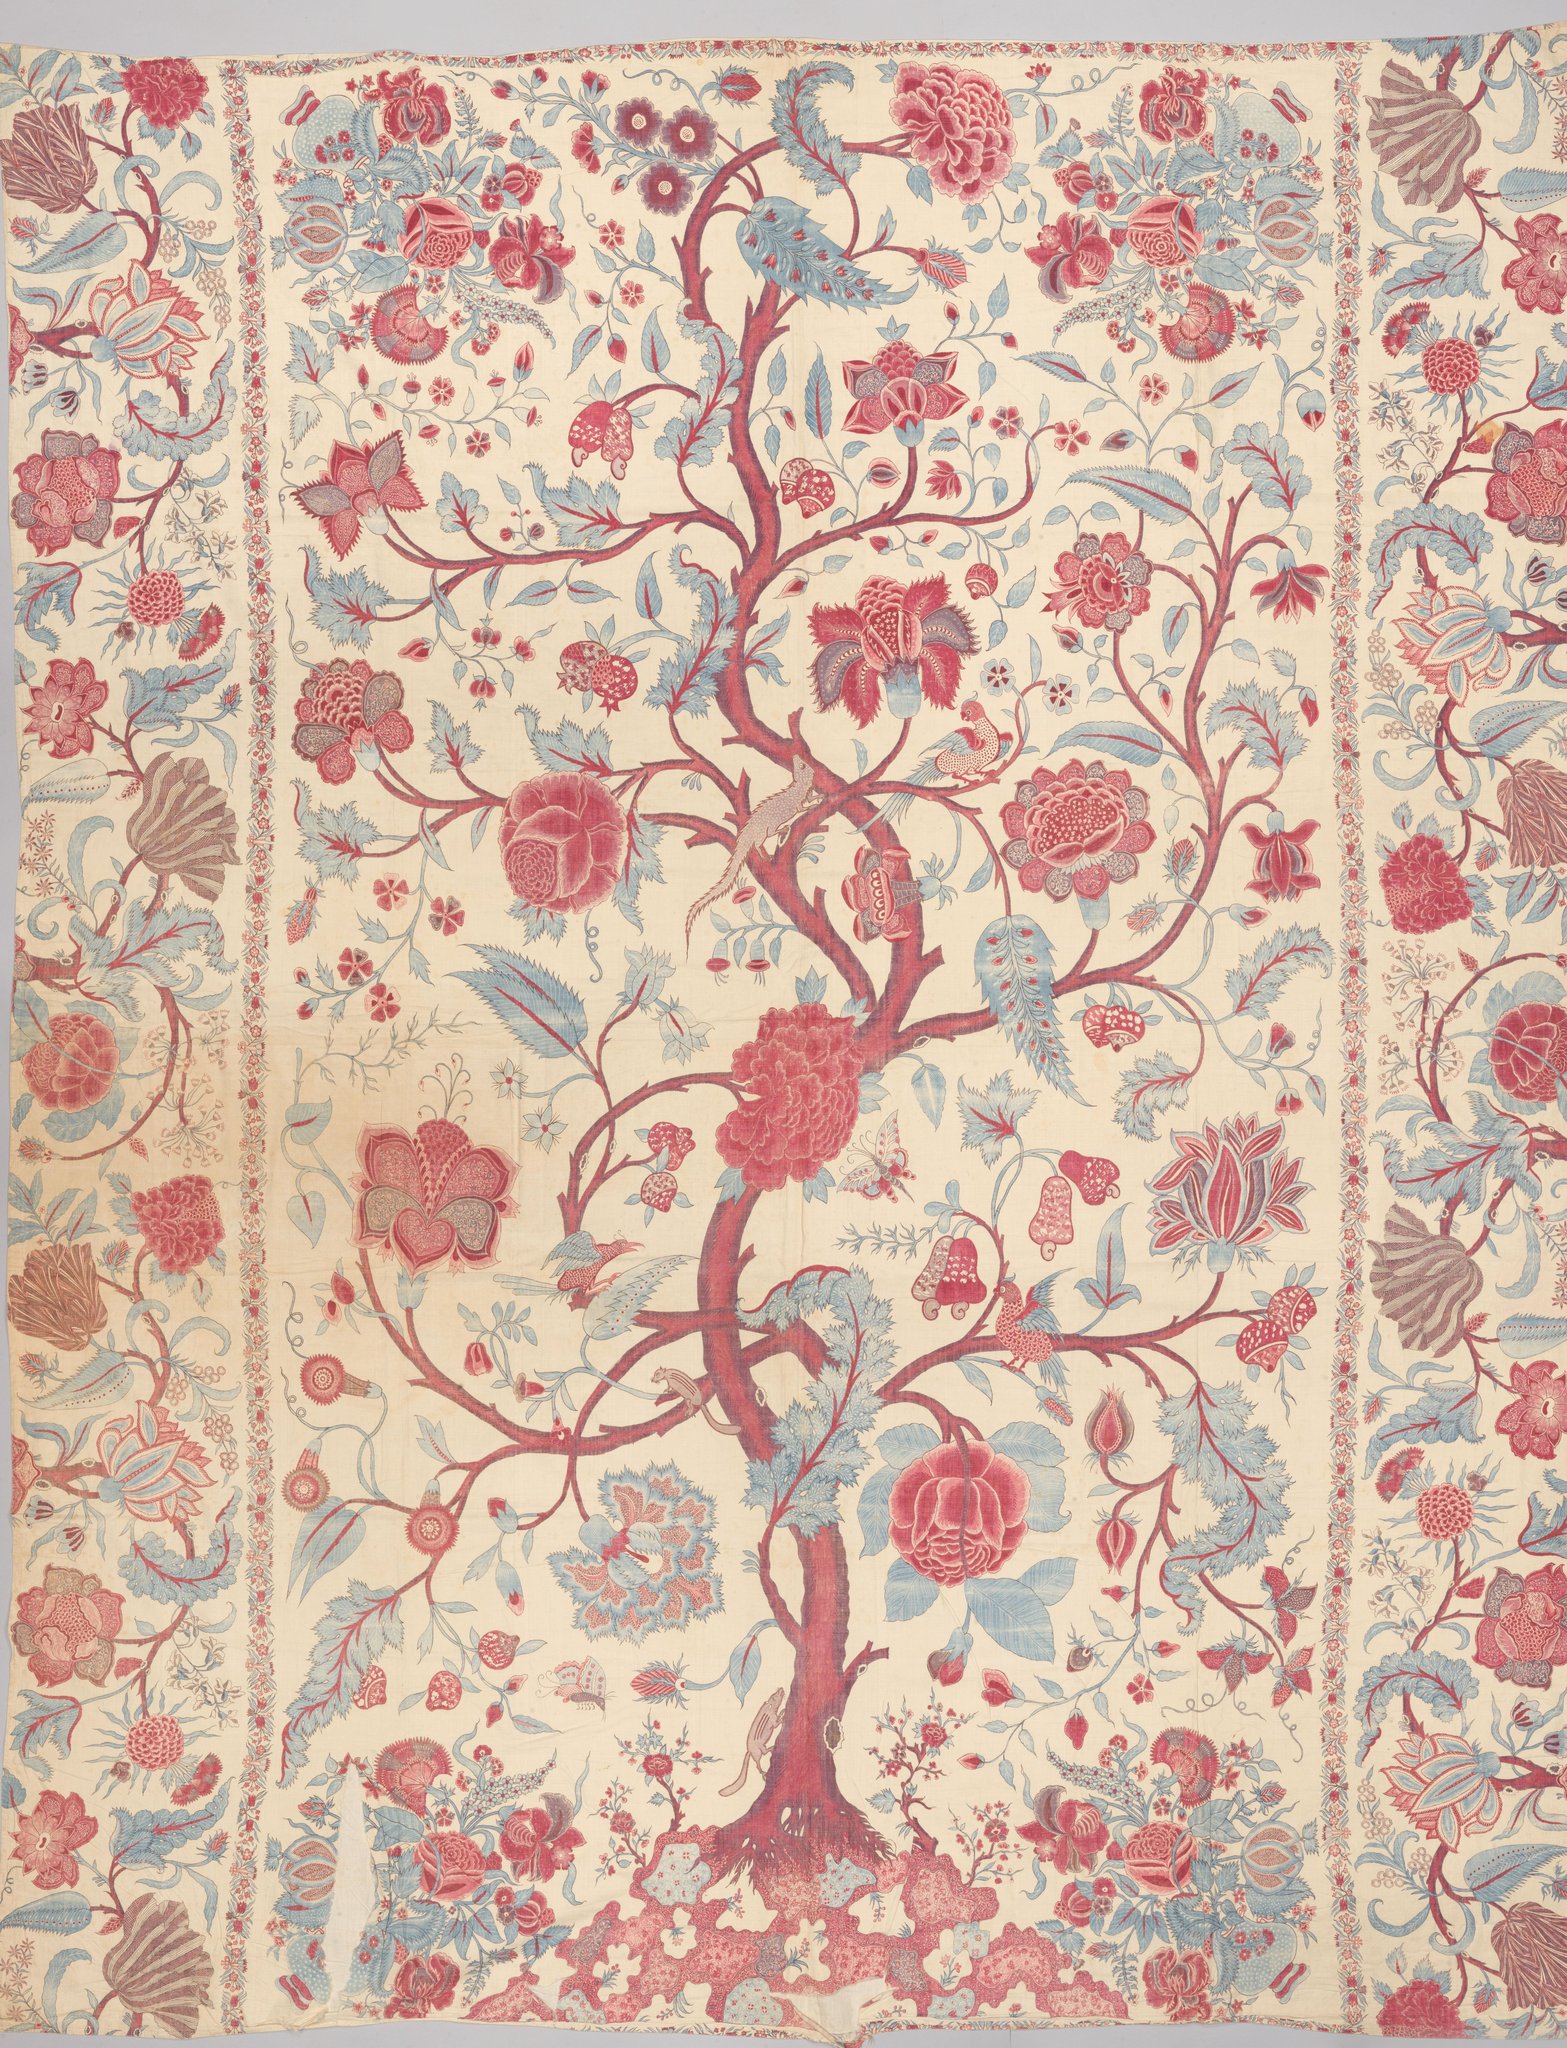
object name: bedspread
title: Sitsen sprei met witte fond met grote serpentine boomstam met middelgrote bloemen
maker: Anonymous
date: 1700-1800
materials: textile, cotton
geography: india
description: Sitsen sprei met op witte fond een grote serpentine boomstam met middelgrote bloemen, vlinders, eekhoorns, hagedissen en vogels in roze en blauw. Ongevoerd, verwassen en verbleekt.